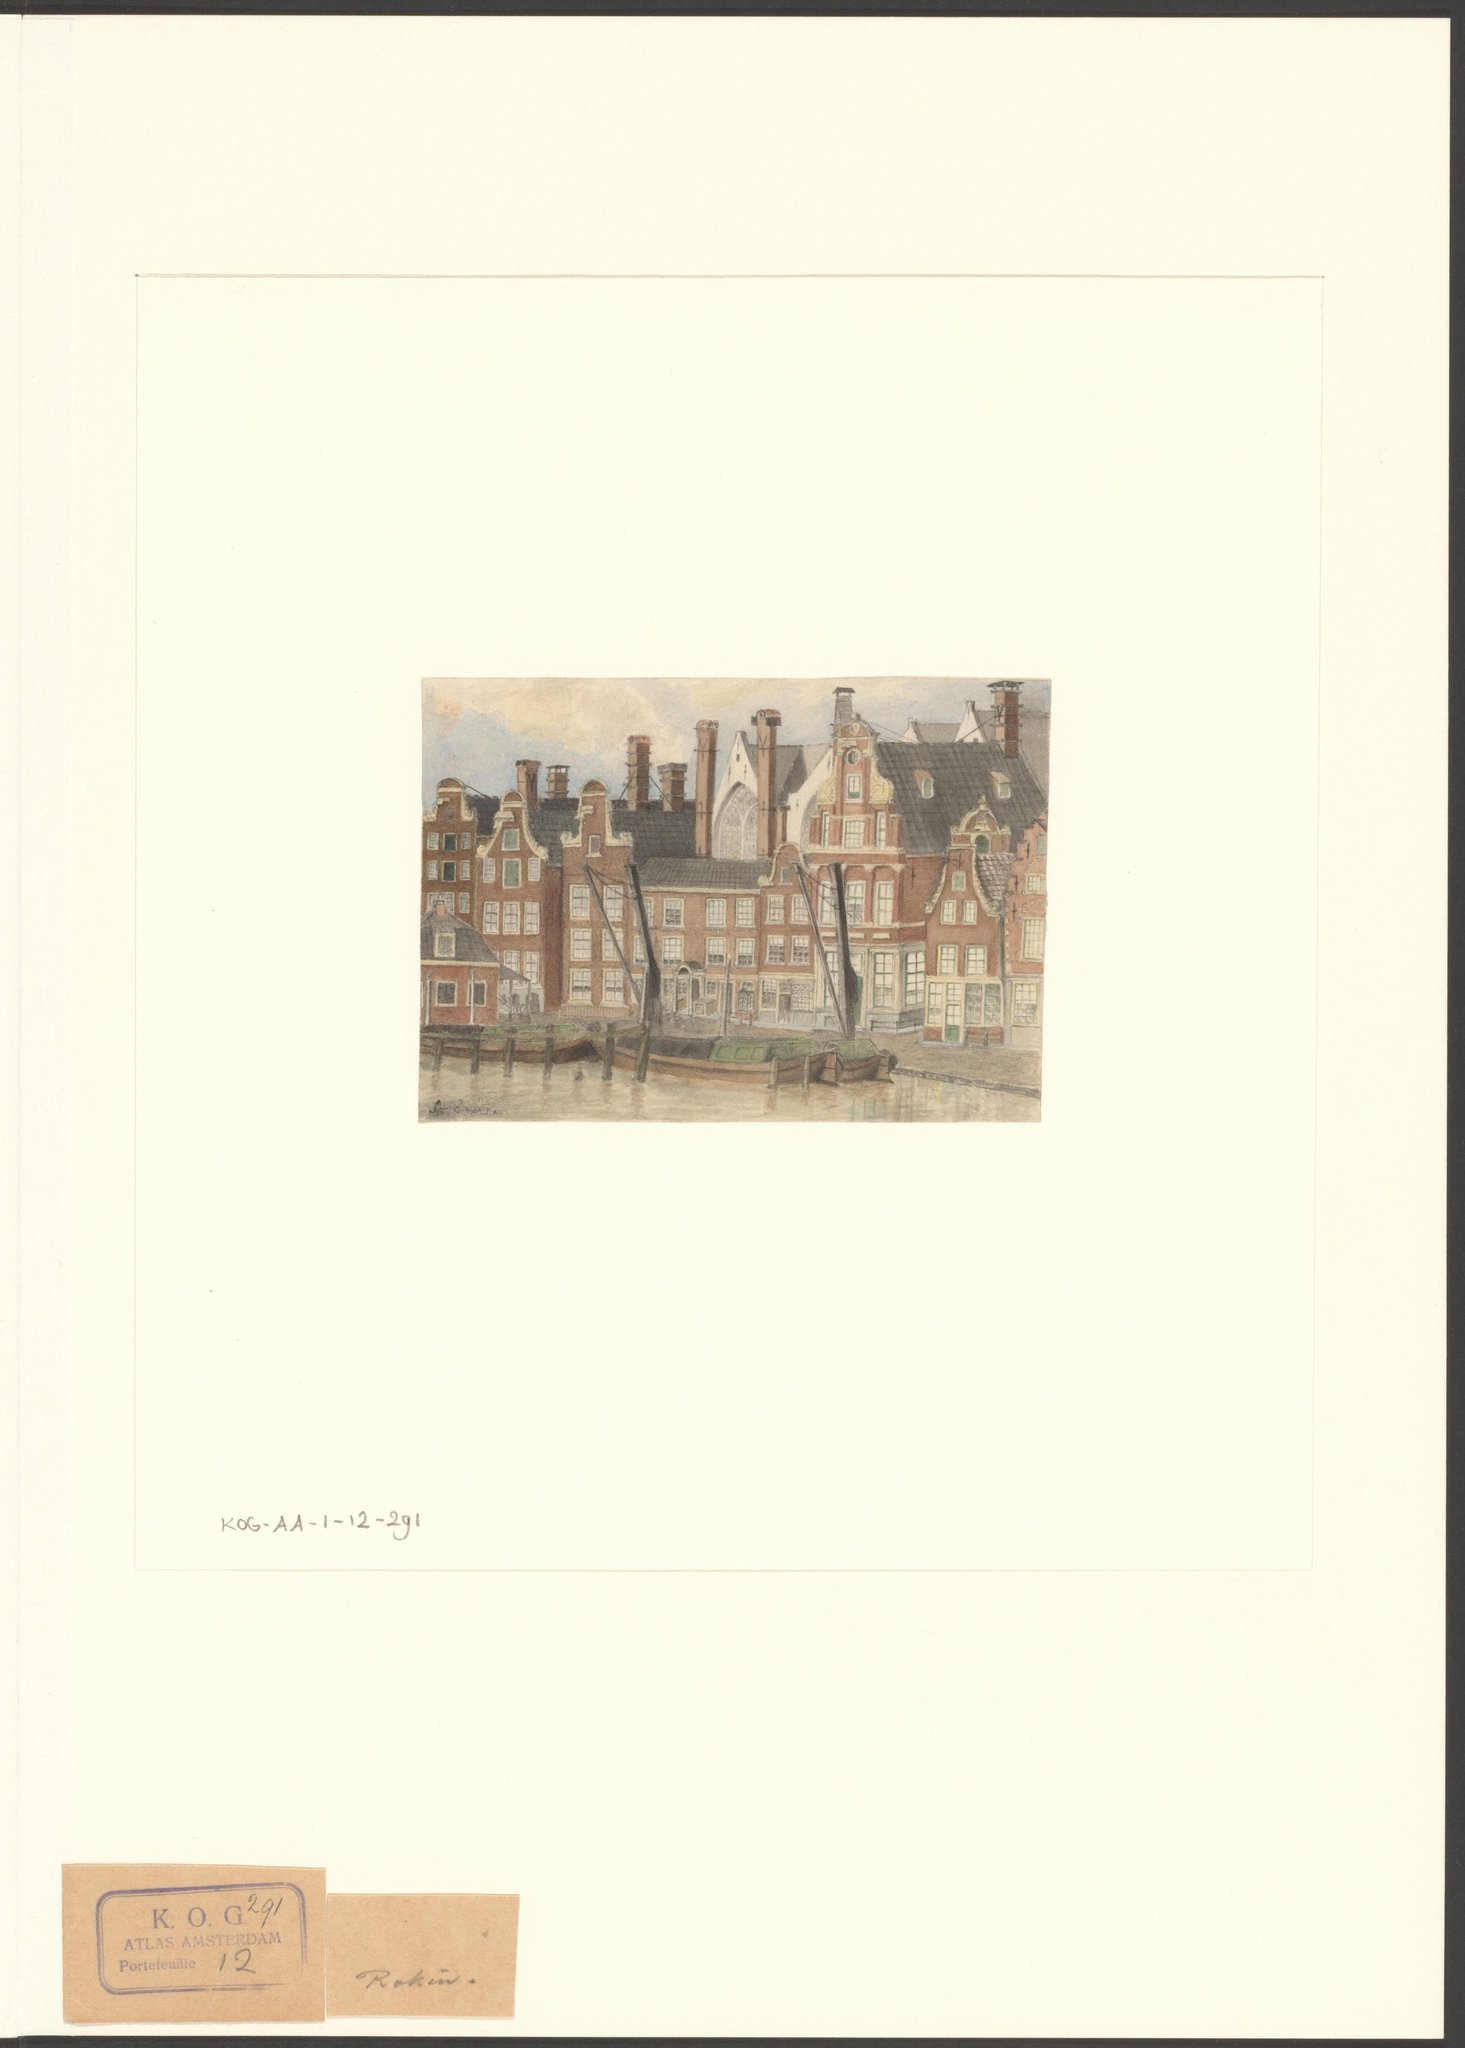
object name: drawing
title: Gezicht op het Rokin, over het water gezien naar de Nieuwezijds Kapel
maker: adrianus eversen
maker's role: draughtsman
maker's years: 1818-1897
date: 1828-1897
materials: ink, paper, pencil, watercolor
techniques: brush, pen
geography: amsterdam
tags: city-view in general; 'veduta', canal, the usual house or row of houses, street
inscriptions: inscription: ‘Port. 12 / 291’, signature: ‘A. Eversen’, collector's mark: ‘12’ Lugt 1641b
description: Onderwerpsrubriek binnen de Atlas Amsterdam: Rokin, Rotterdammersloot, Rozengang, Rozengracht, Rozenstraat, Rusland, Rustenburgerstraat, Ruysdaelkade, Ruysdaelstraat, Ruyterkade (de), Ruyterweg (Admiraal de).